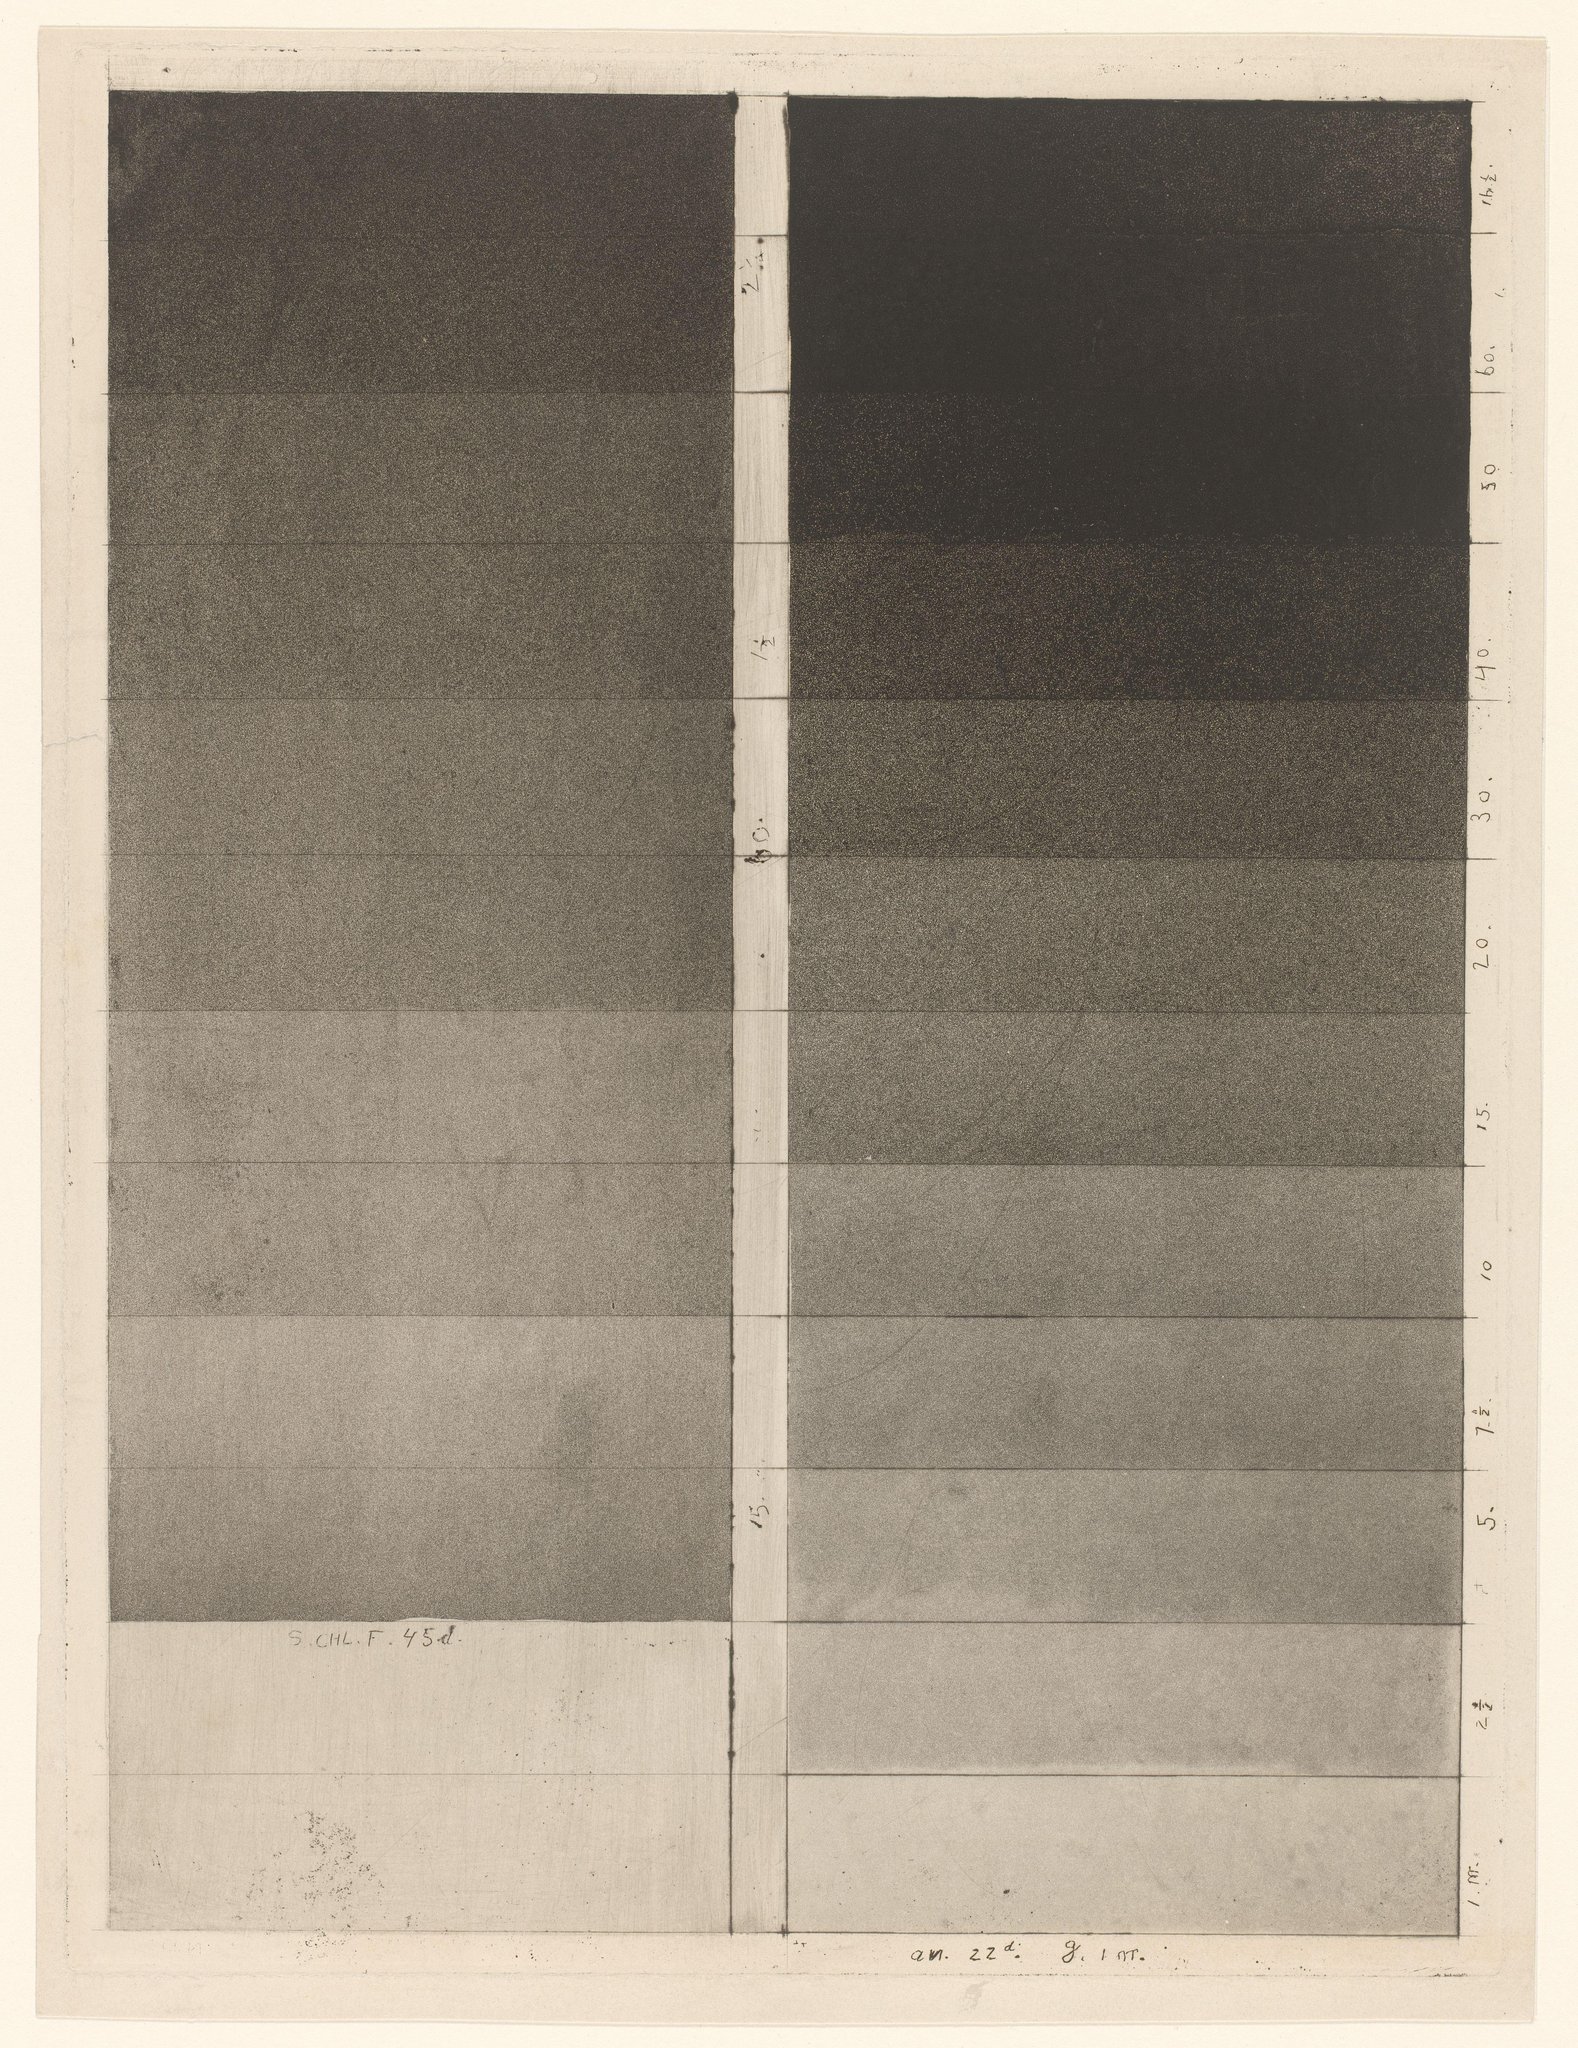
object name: print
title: Proeven van aquatint-greinen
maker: emanuel samson van beever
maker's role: draughtsman, painter, print maker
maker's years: 1876-1912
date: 1886-1912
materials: paper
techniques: aquatint, intaglio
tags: test, trial (~ production)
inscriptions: collector's mark: Lugt 2233